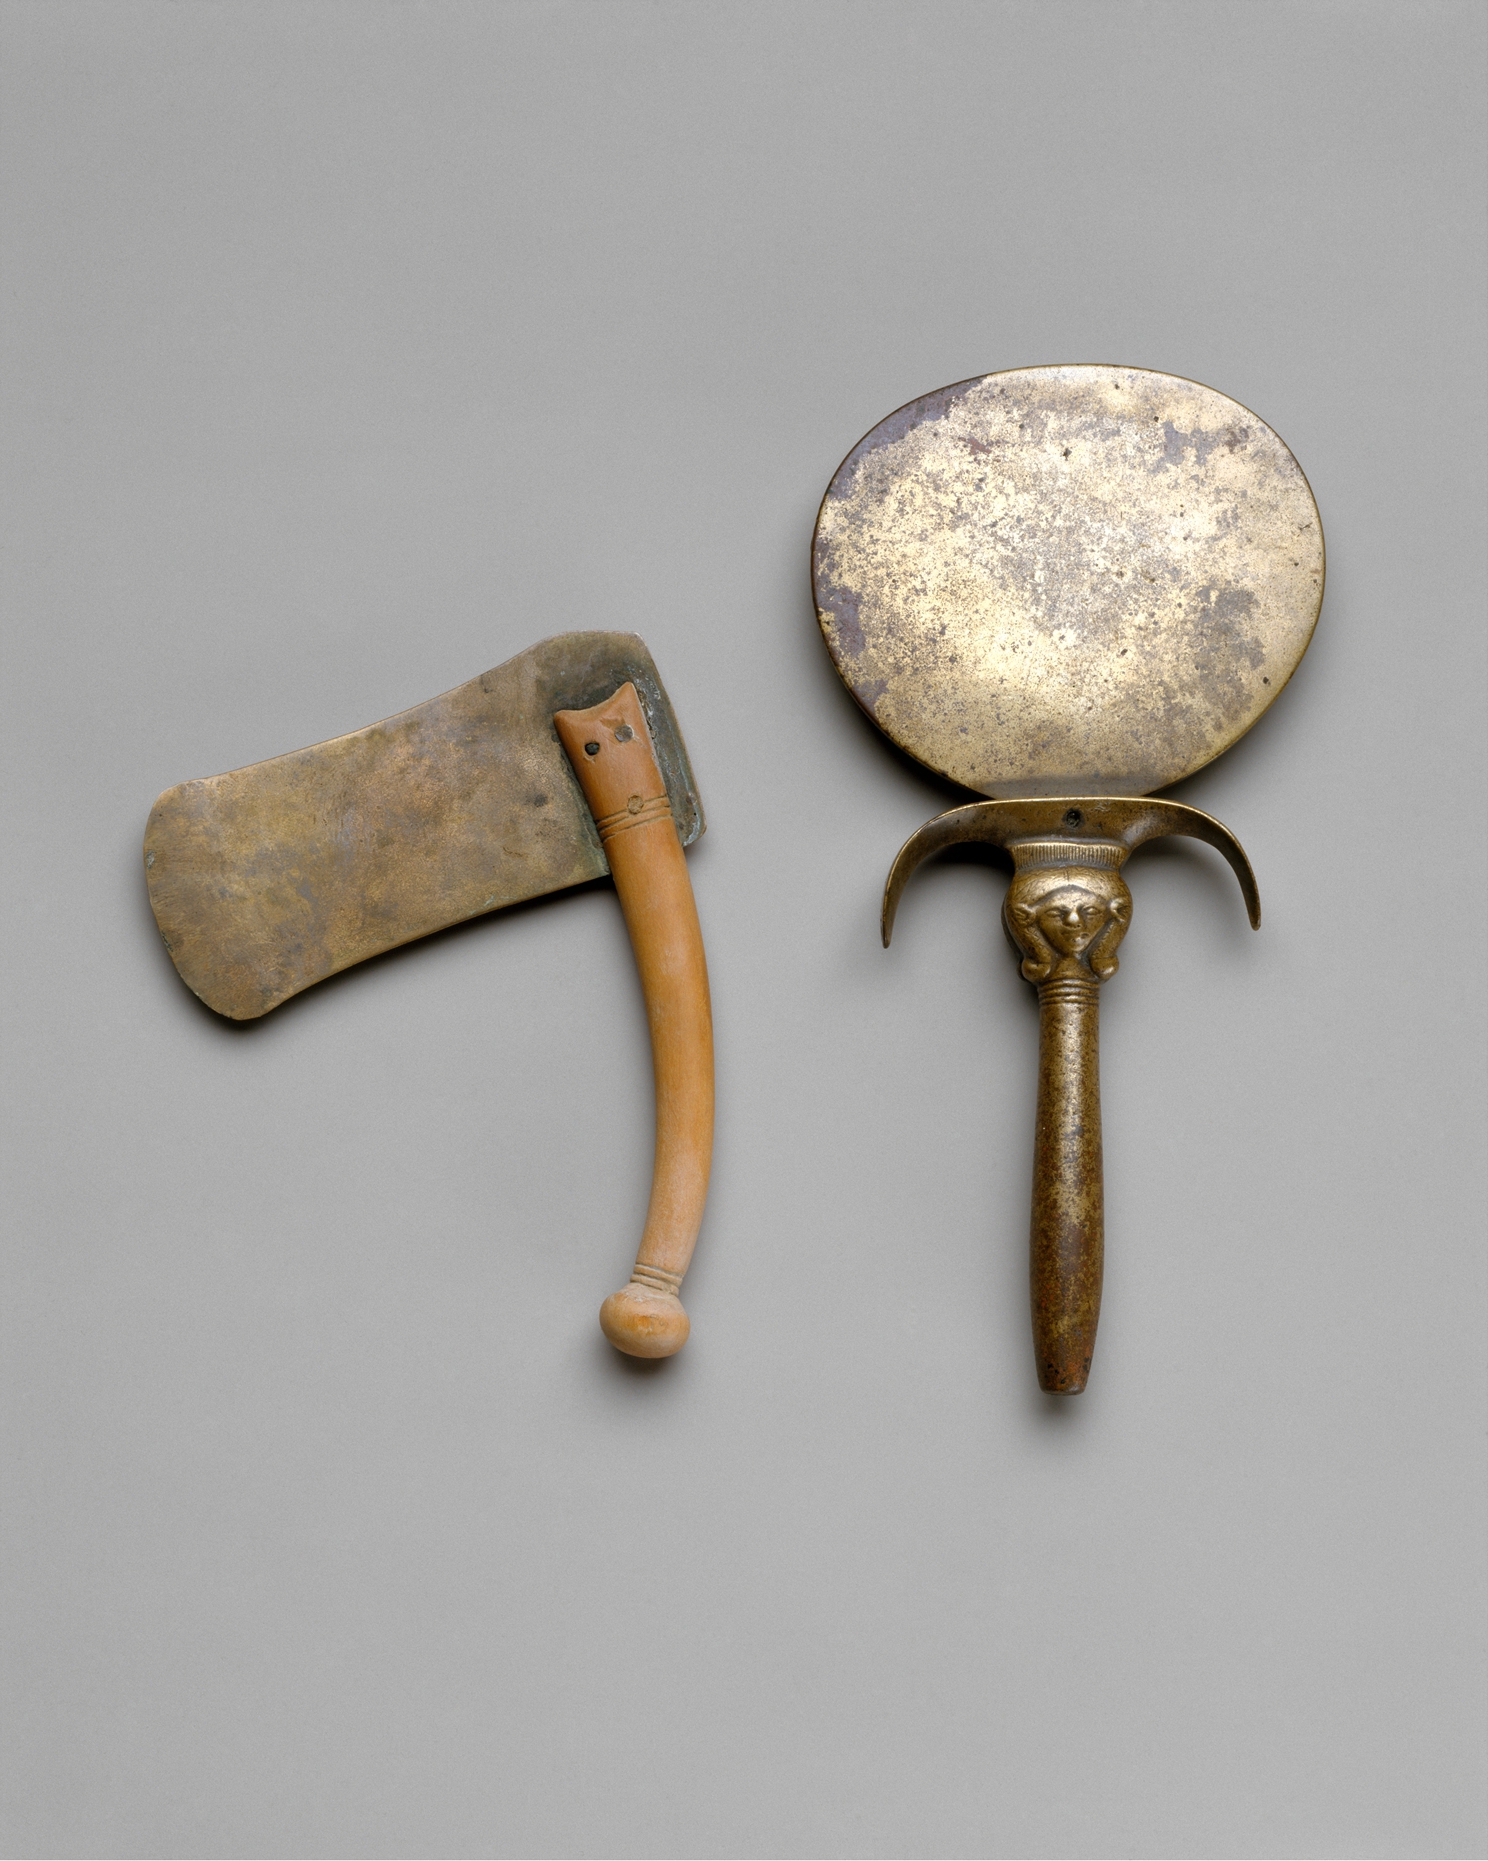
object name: razor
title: Razor and mirror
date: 1492-1473 BCE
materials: wood, bronze, copper alloy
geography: egypt